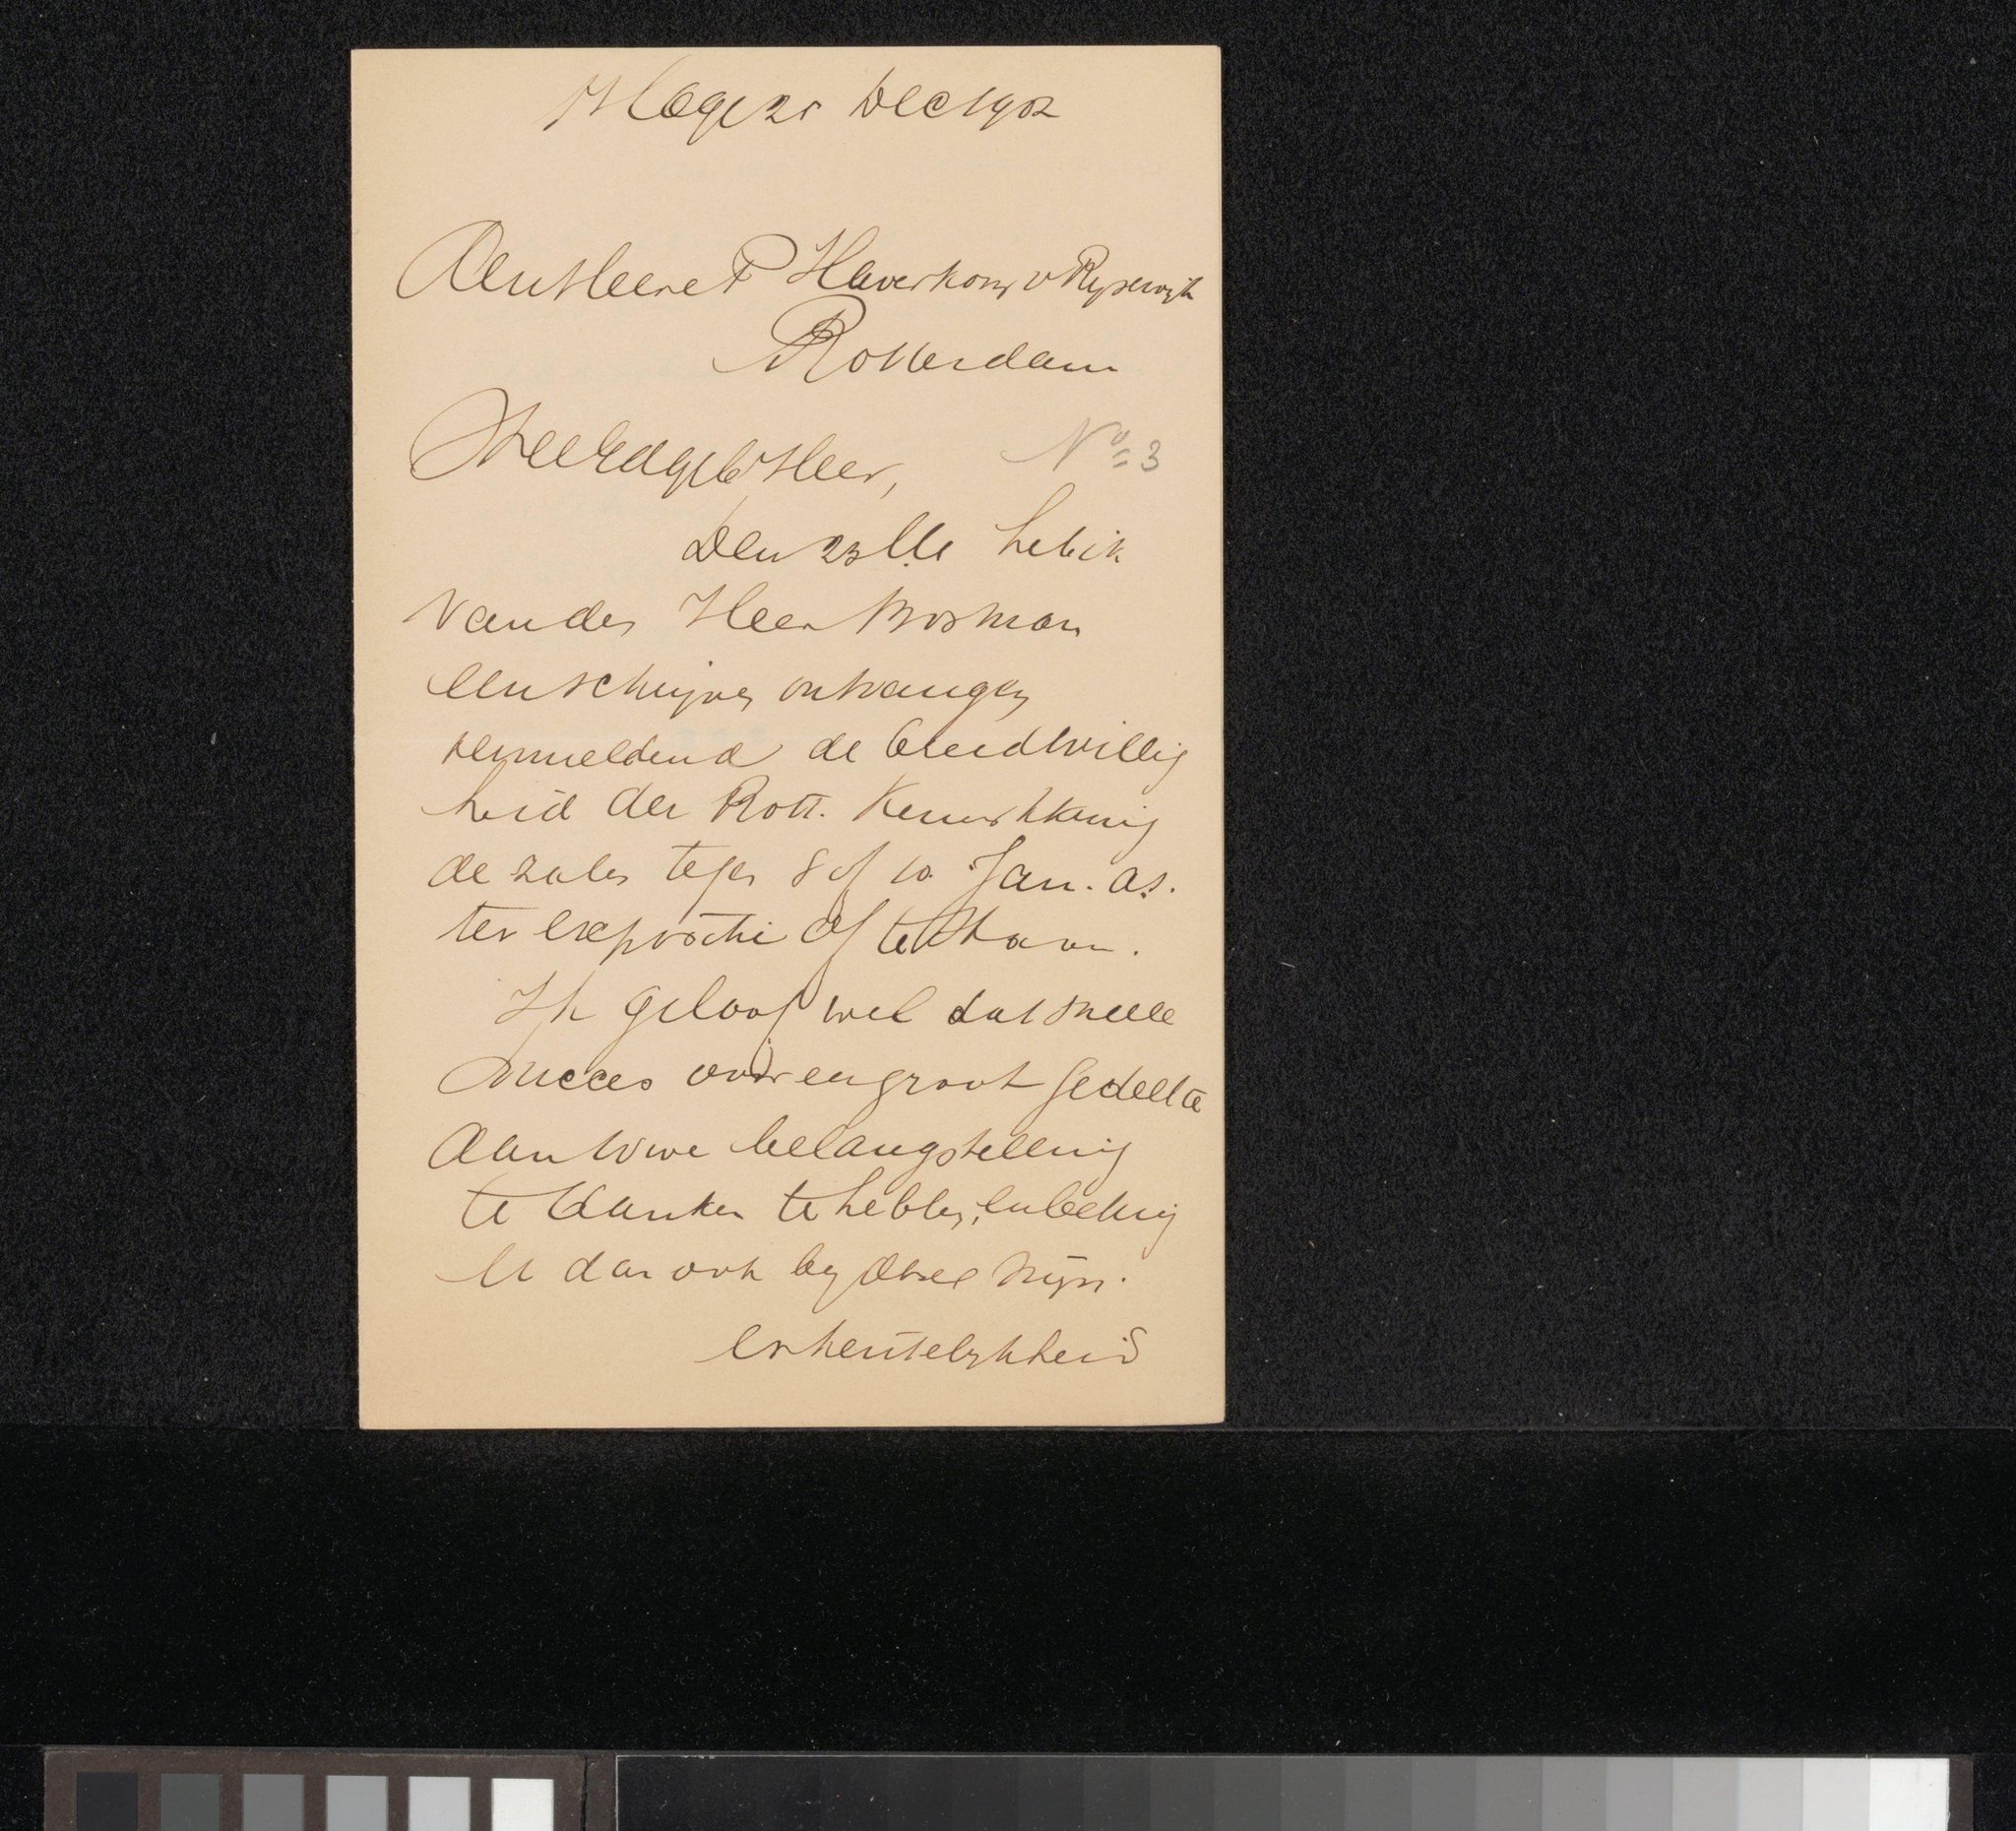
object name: letter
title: Brief aan Pieter Haverkorn van Rijsewijk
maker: johannes josephus aarts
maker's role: draughtsman, print maker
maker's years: 1871-1934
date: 1902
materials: ink, paper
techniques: pen, writing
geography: the hague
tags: pieter haverkorn van rijsewijk, exhibition ~ art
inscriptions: collector's mark: ‘RPK’